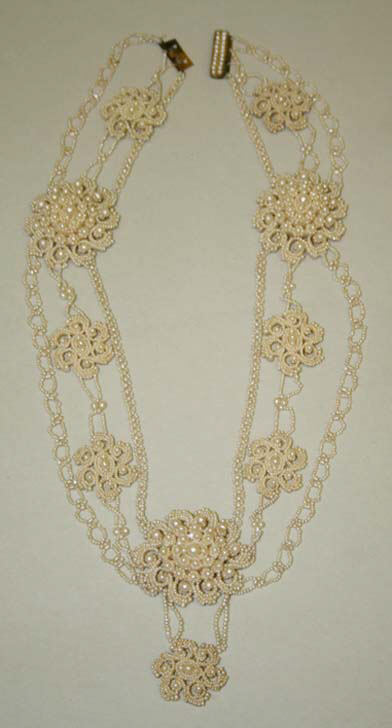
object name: necklace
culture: american or european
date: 1801-1900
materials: pearl